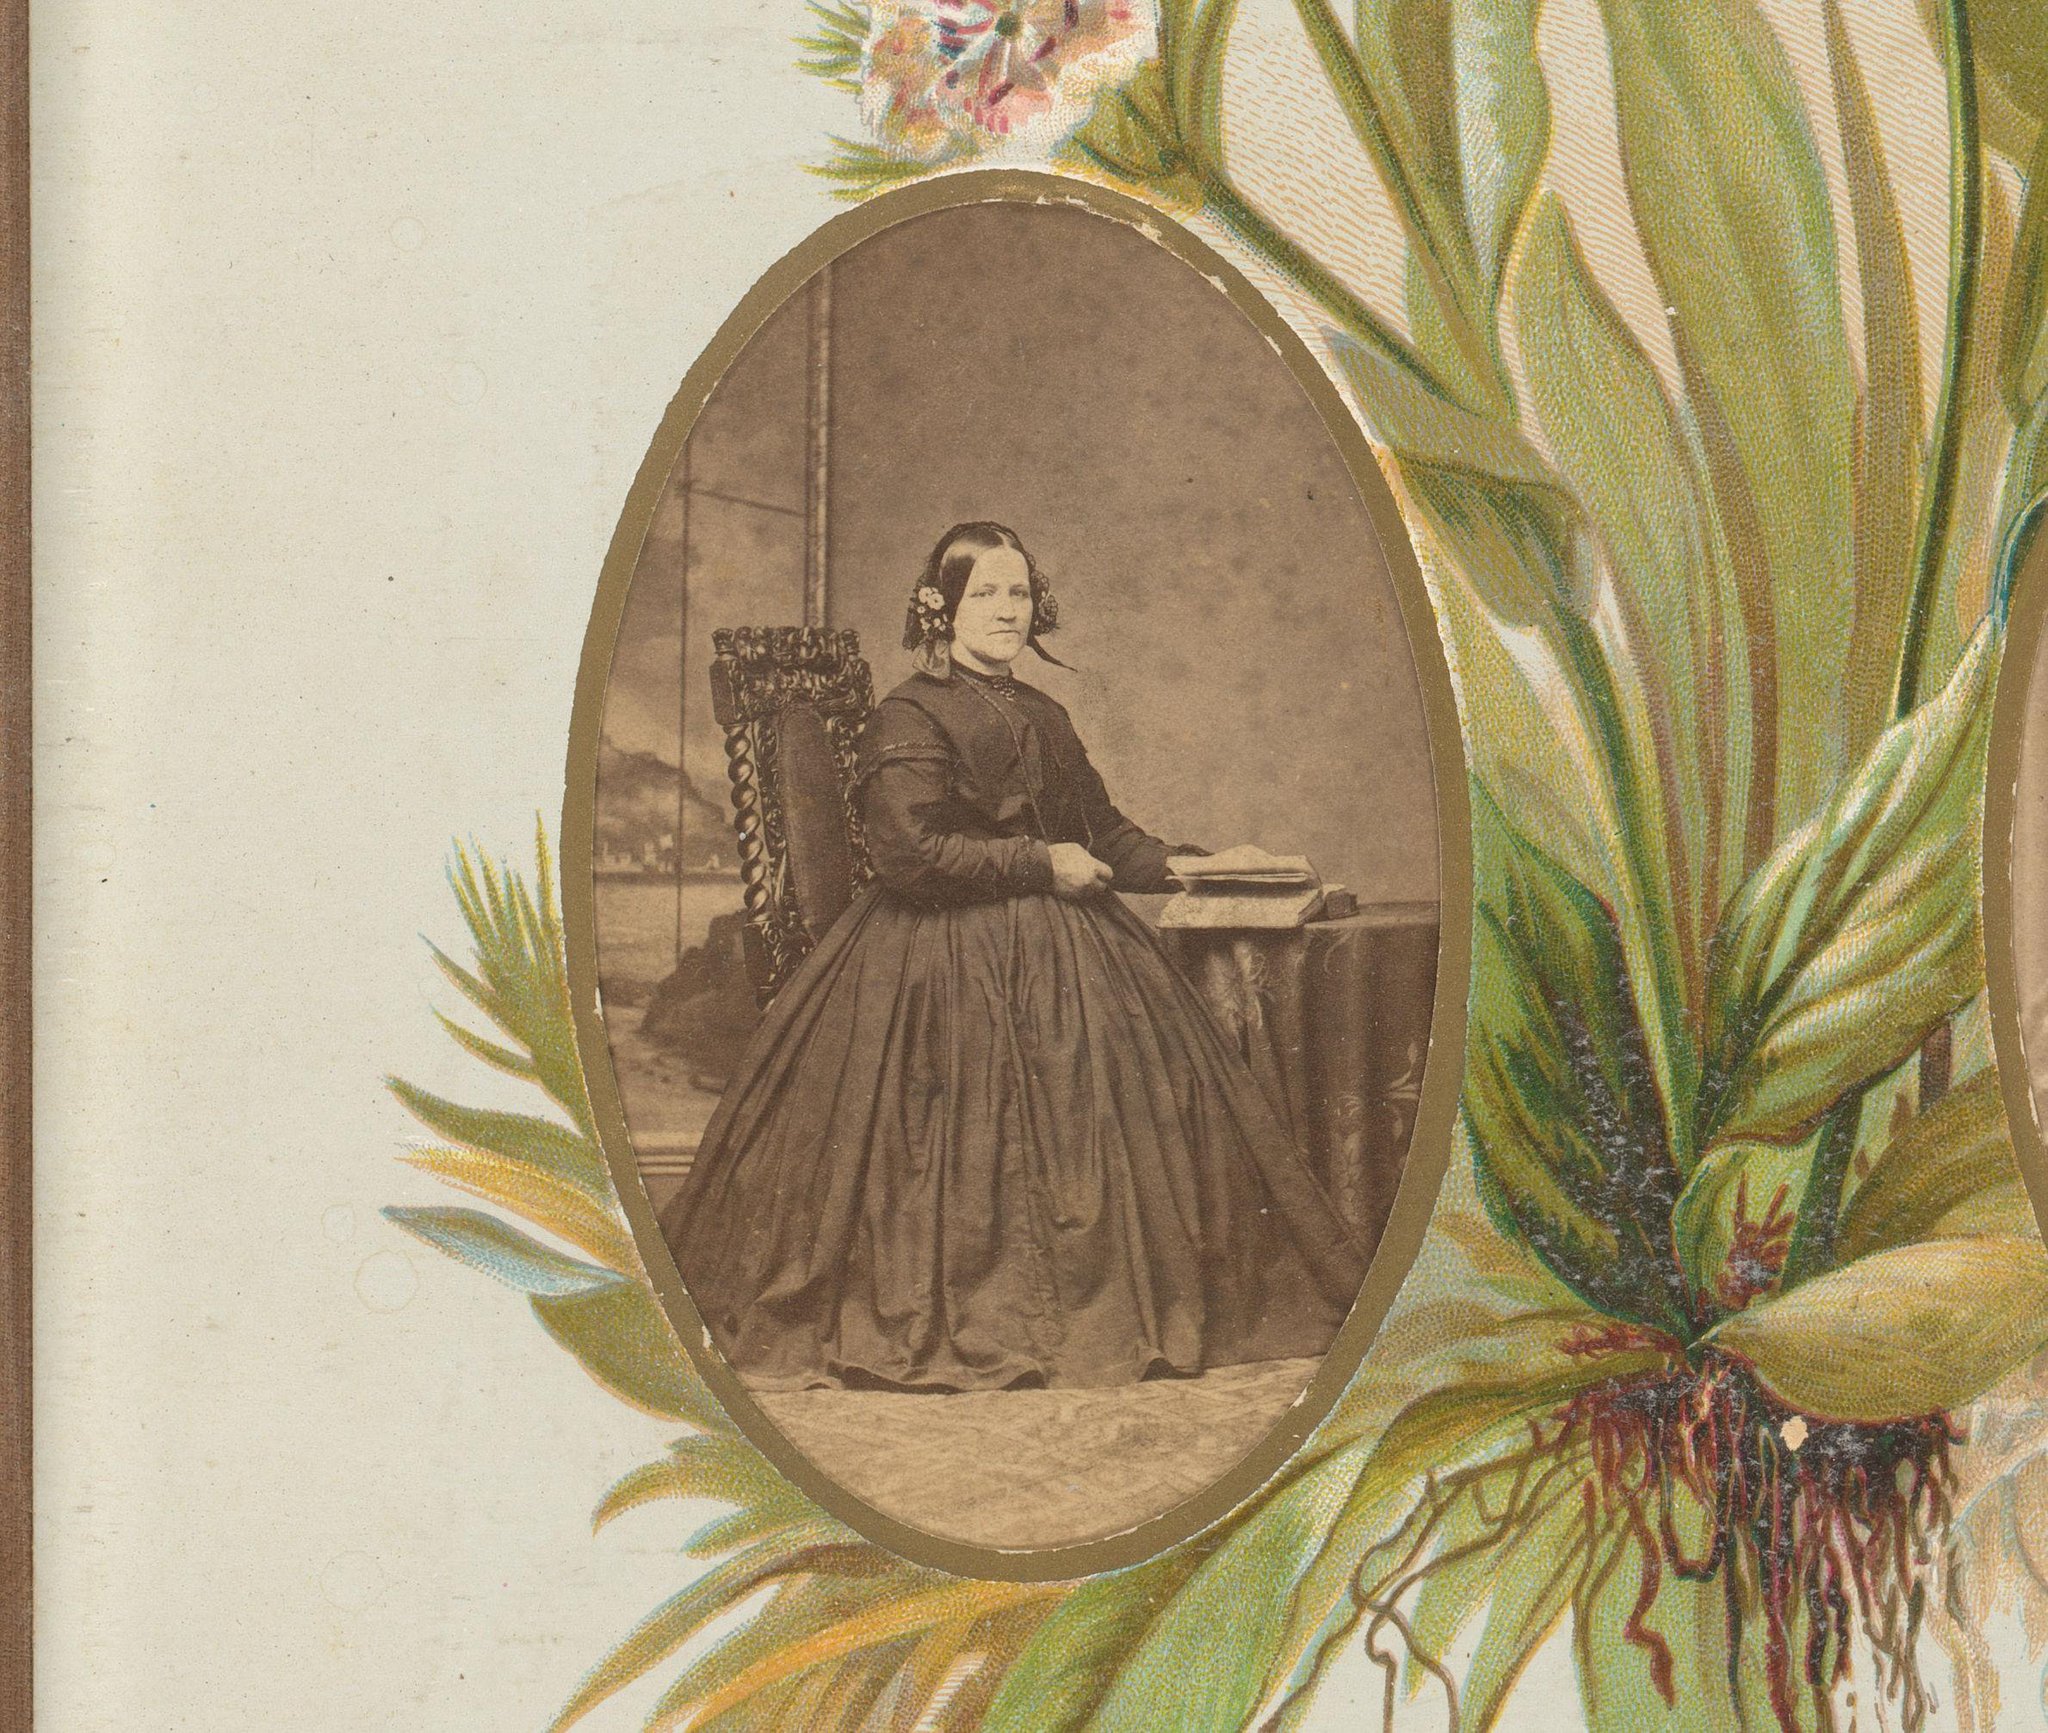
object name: album leaf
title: Portret van een vrouw, zittend aan een tafel met opengeslagen boek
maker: john cann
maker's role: fotograaf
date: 1860-1900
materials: cardboard, photographic support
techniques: albumen print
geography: tiverton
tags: sitting figure - aa - female human figure, historical persons - bb - woman, book - mm - book open, table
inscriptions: inscription: ‘JOHN CANN/ PHOTOGRAPHER/ TIVERTON’